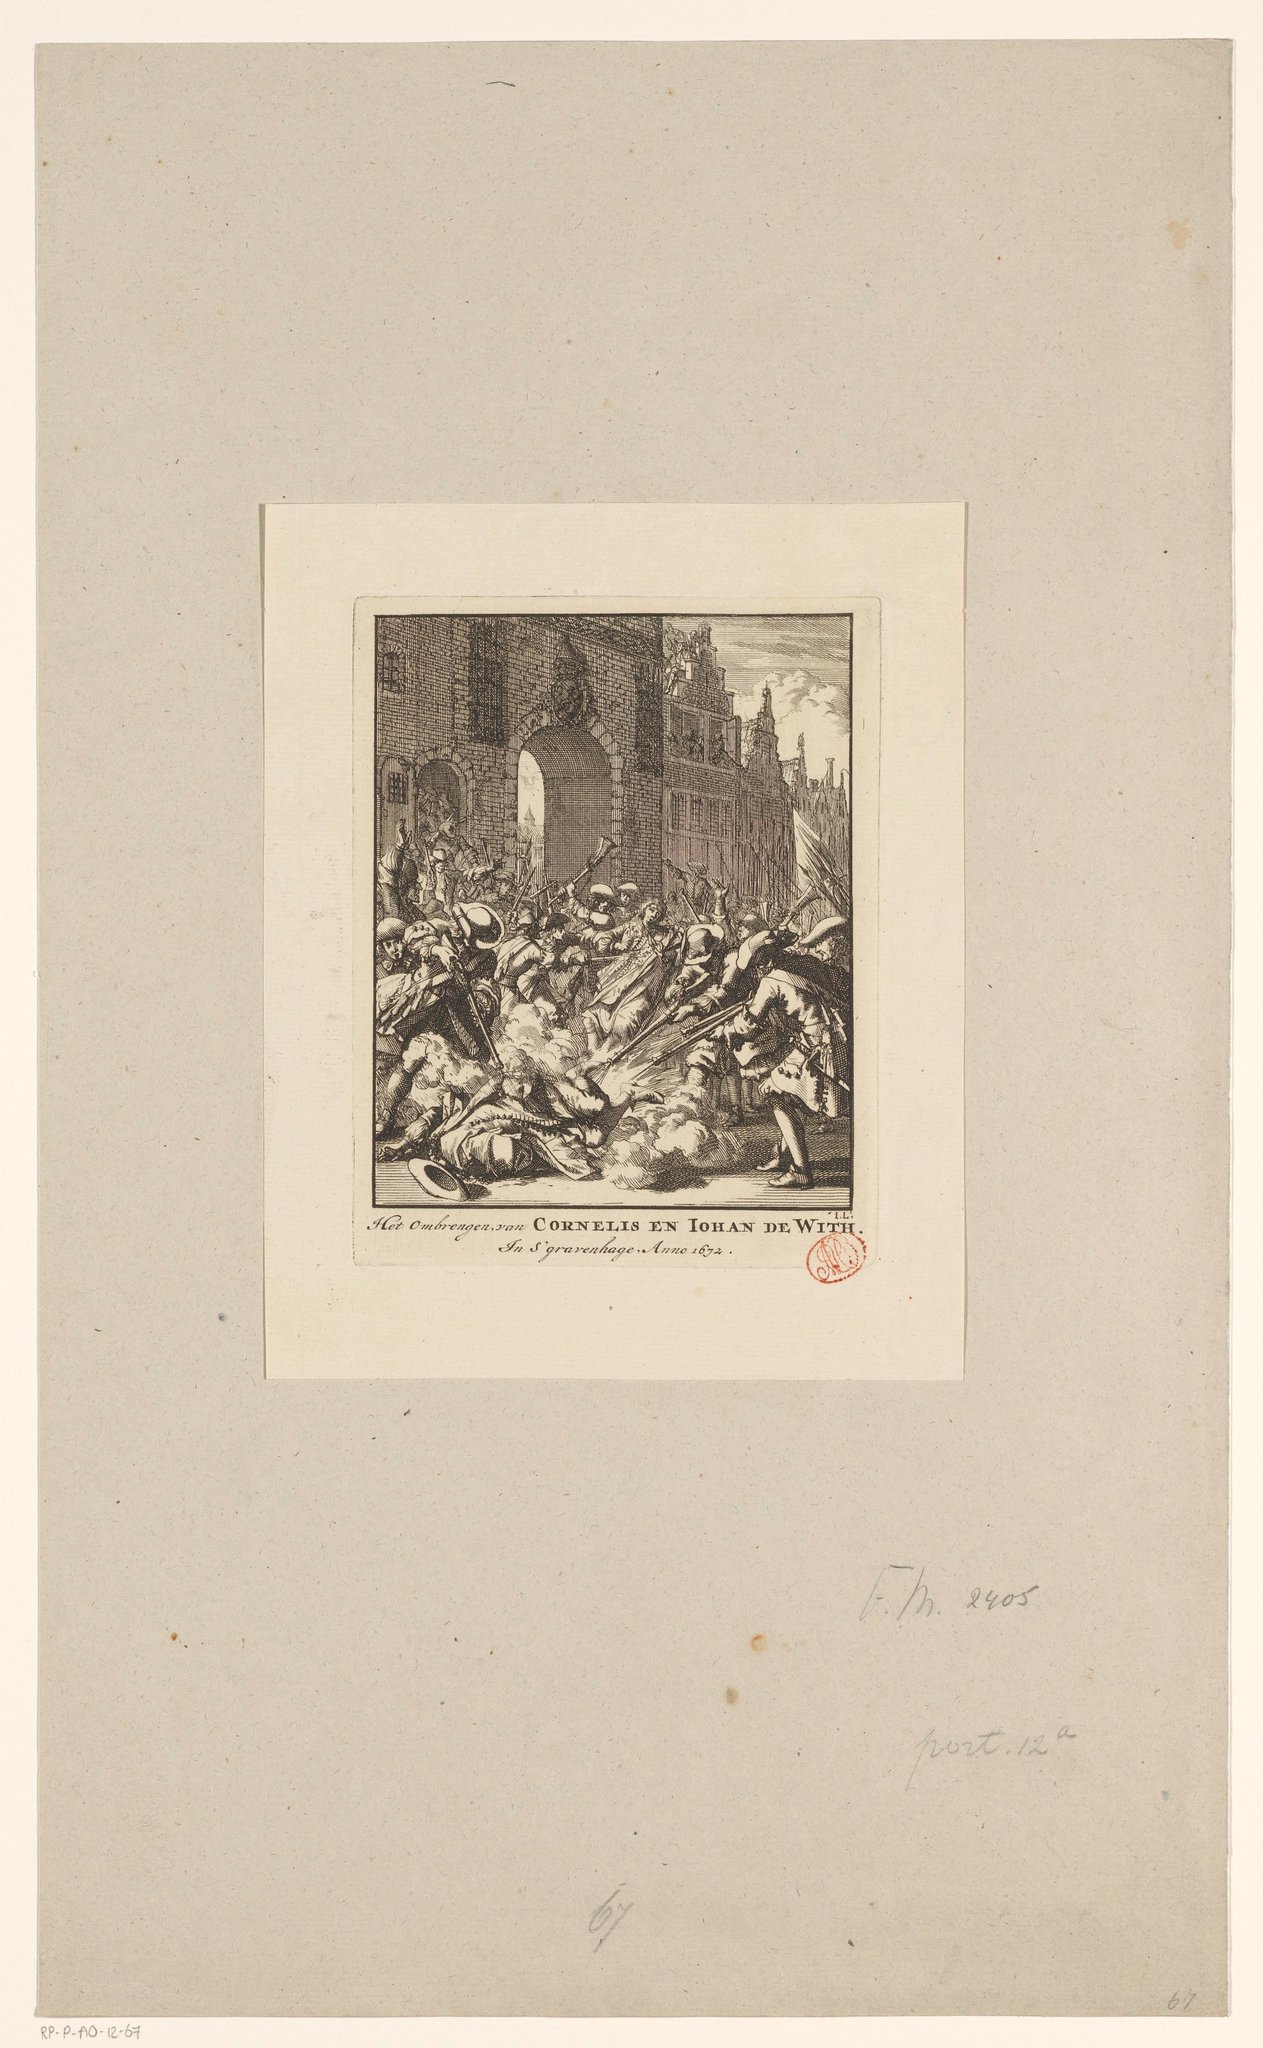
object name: print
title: Het ombrengen van Cornelis en Iohan de With. In s'Gravenhage anno 1672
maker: jan luyken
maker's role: draughtsman, print maker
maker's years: 1649-1712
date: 1698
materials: paper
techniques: engraving, etching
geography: amsterdam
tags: dordrecht, cornelis de witt, the hague, johan de witt, lynching, attempt, political murder, violent death, being killed; being mishandled and maltreated; seeking death (+ death by lynching)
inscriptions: collector's mark: Lugt 195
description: Andere staat van prent ook gebruikt in: Bosch, Lambert van den. Treur-toonneel der doorluchtige mannen, of op- en ondergang der grooten, vertoont in de rampzalige geschiedenissen van (…). 3 delen. Amsterdam: Jan Claesz ten Hoorn, 1698, dl. 3, afd. 6, p. 48.